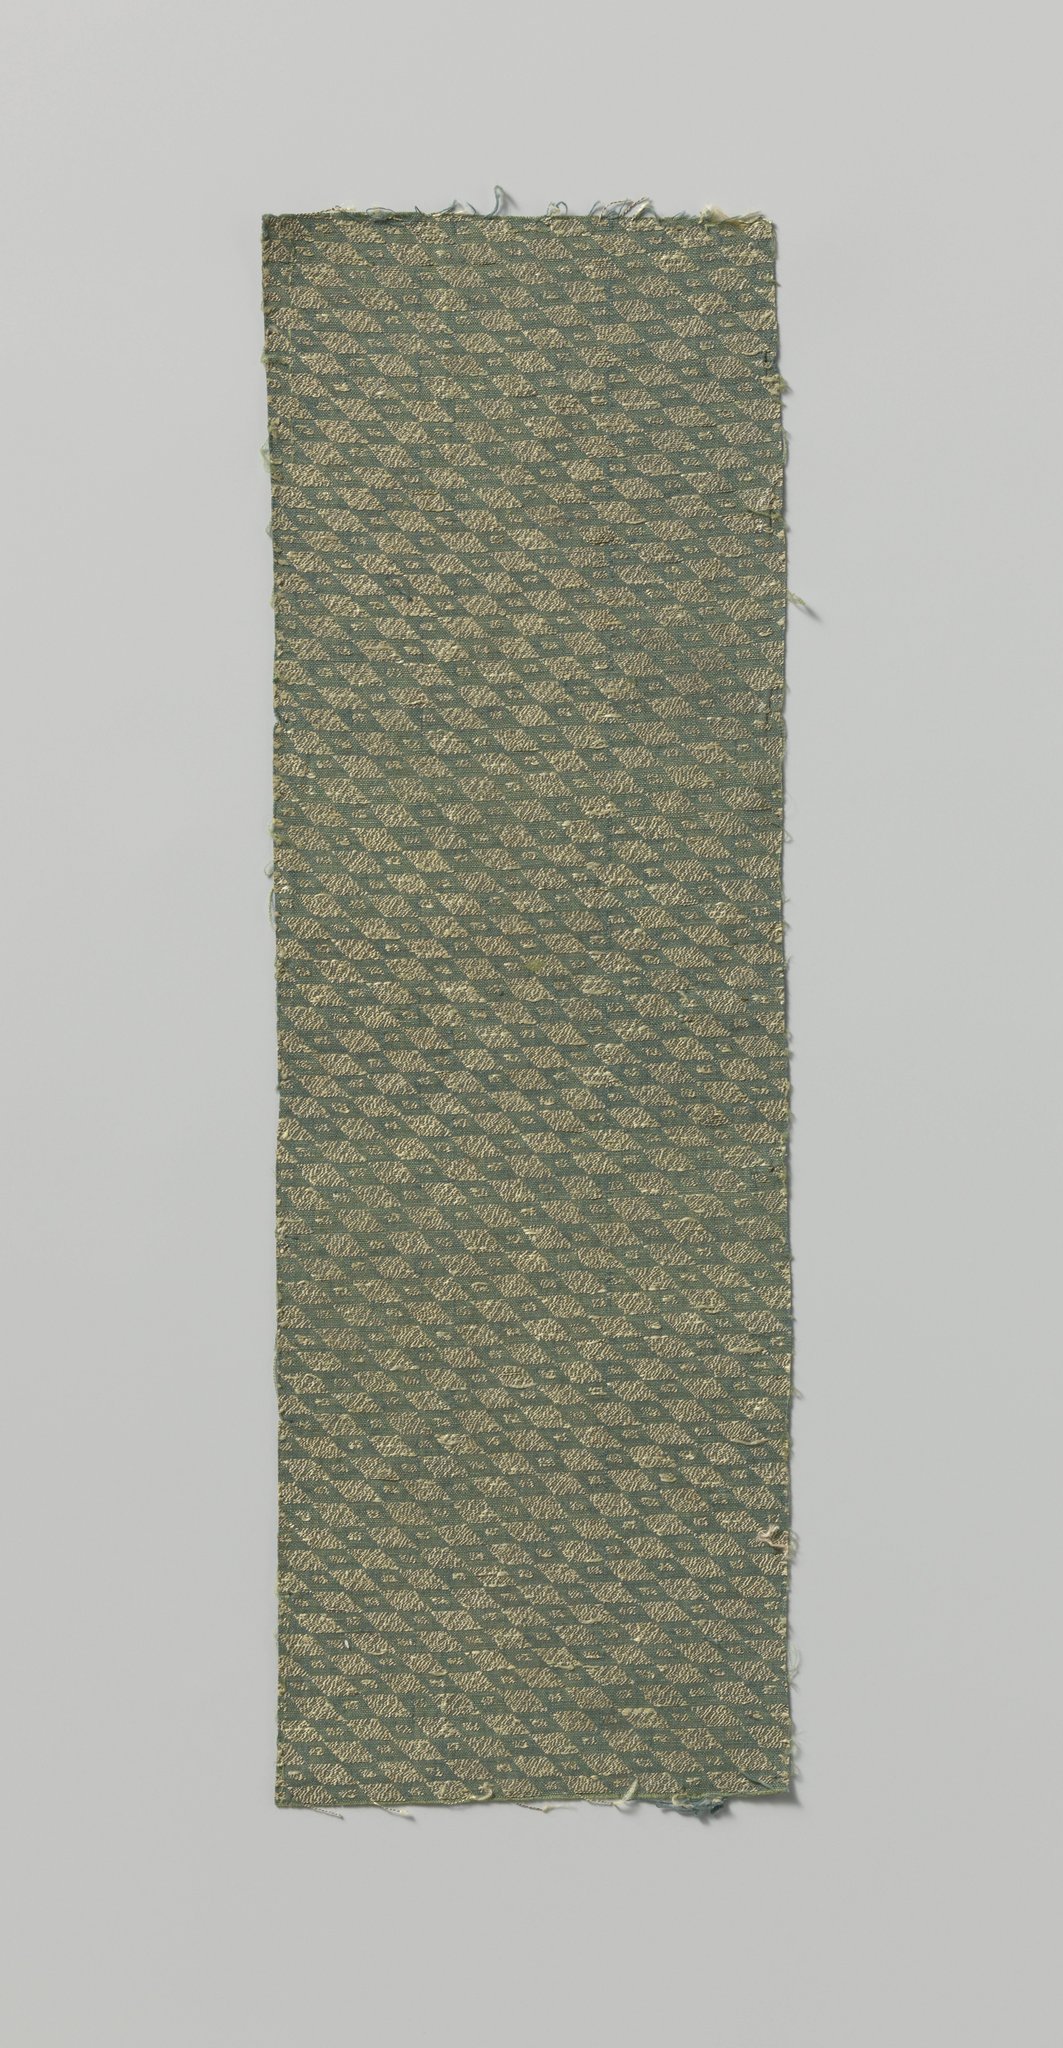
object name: silk textile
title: Fragment oosterse textiel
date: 1800-1850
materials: cotton, silk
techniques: weave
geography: india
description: Fragment oosterse textiel met een ruitpatroon. Het ruitpatroon heeft goudkleurige en groene ruiten. In de groene ruiten zit een kleine zilverkleurige ruit.